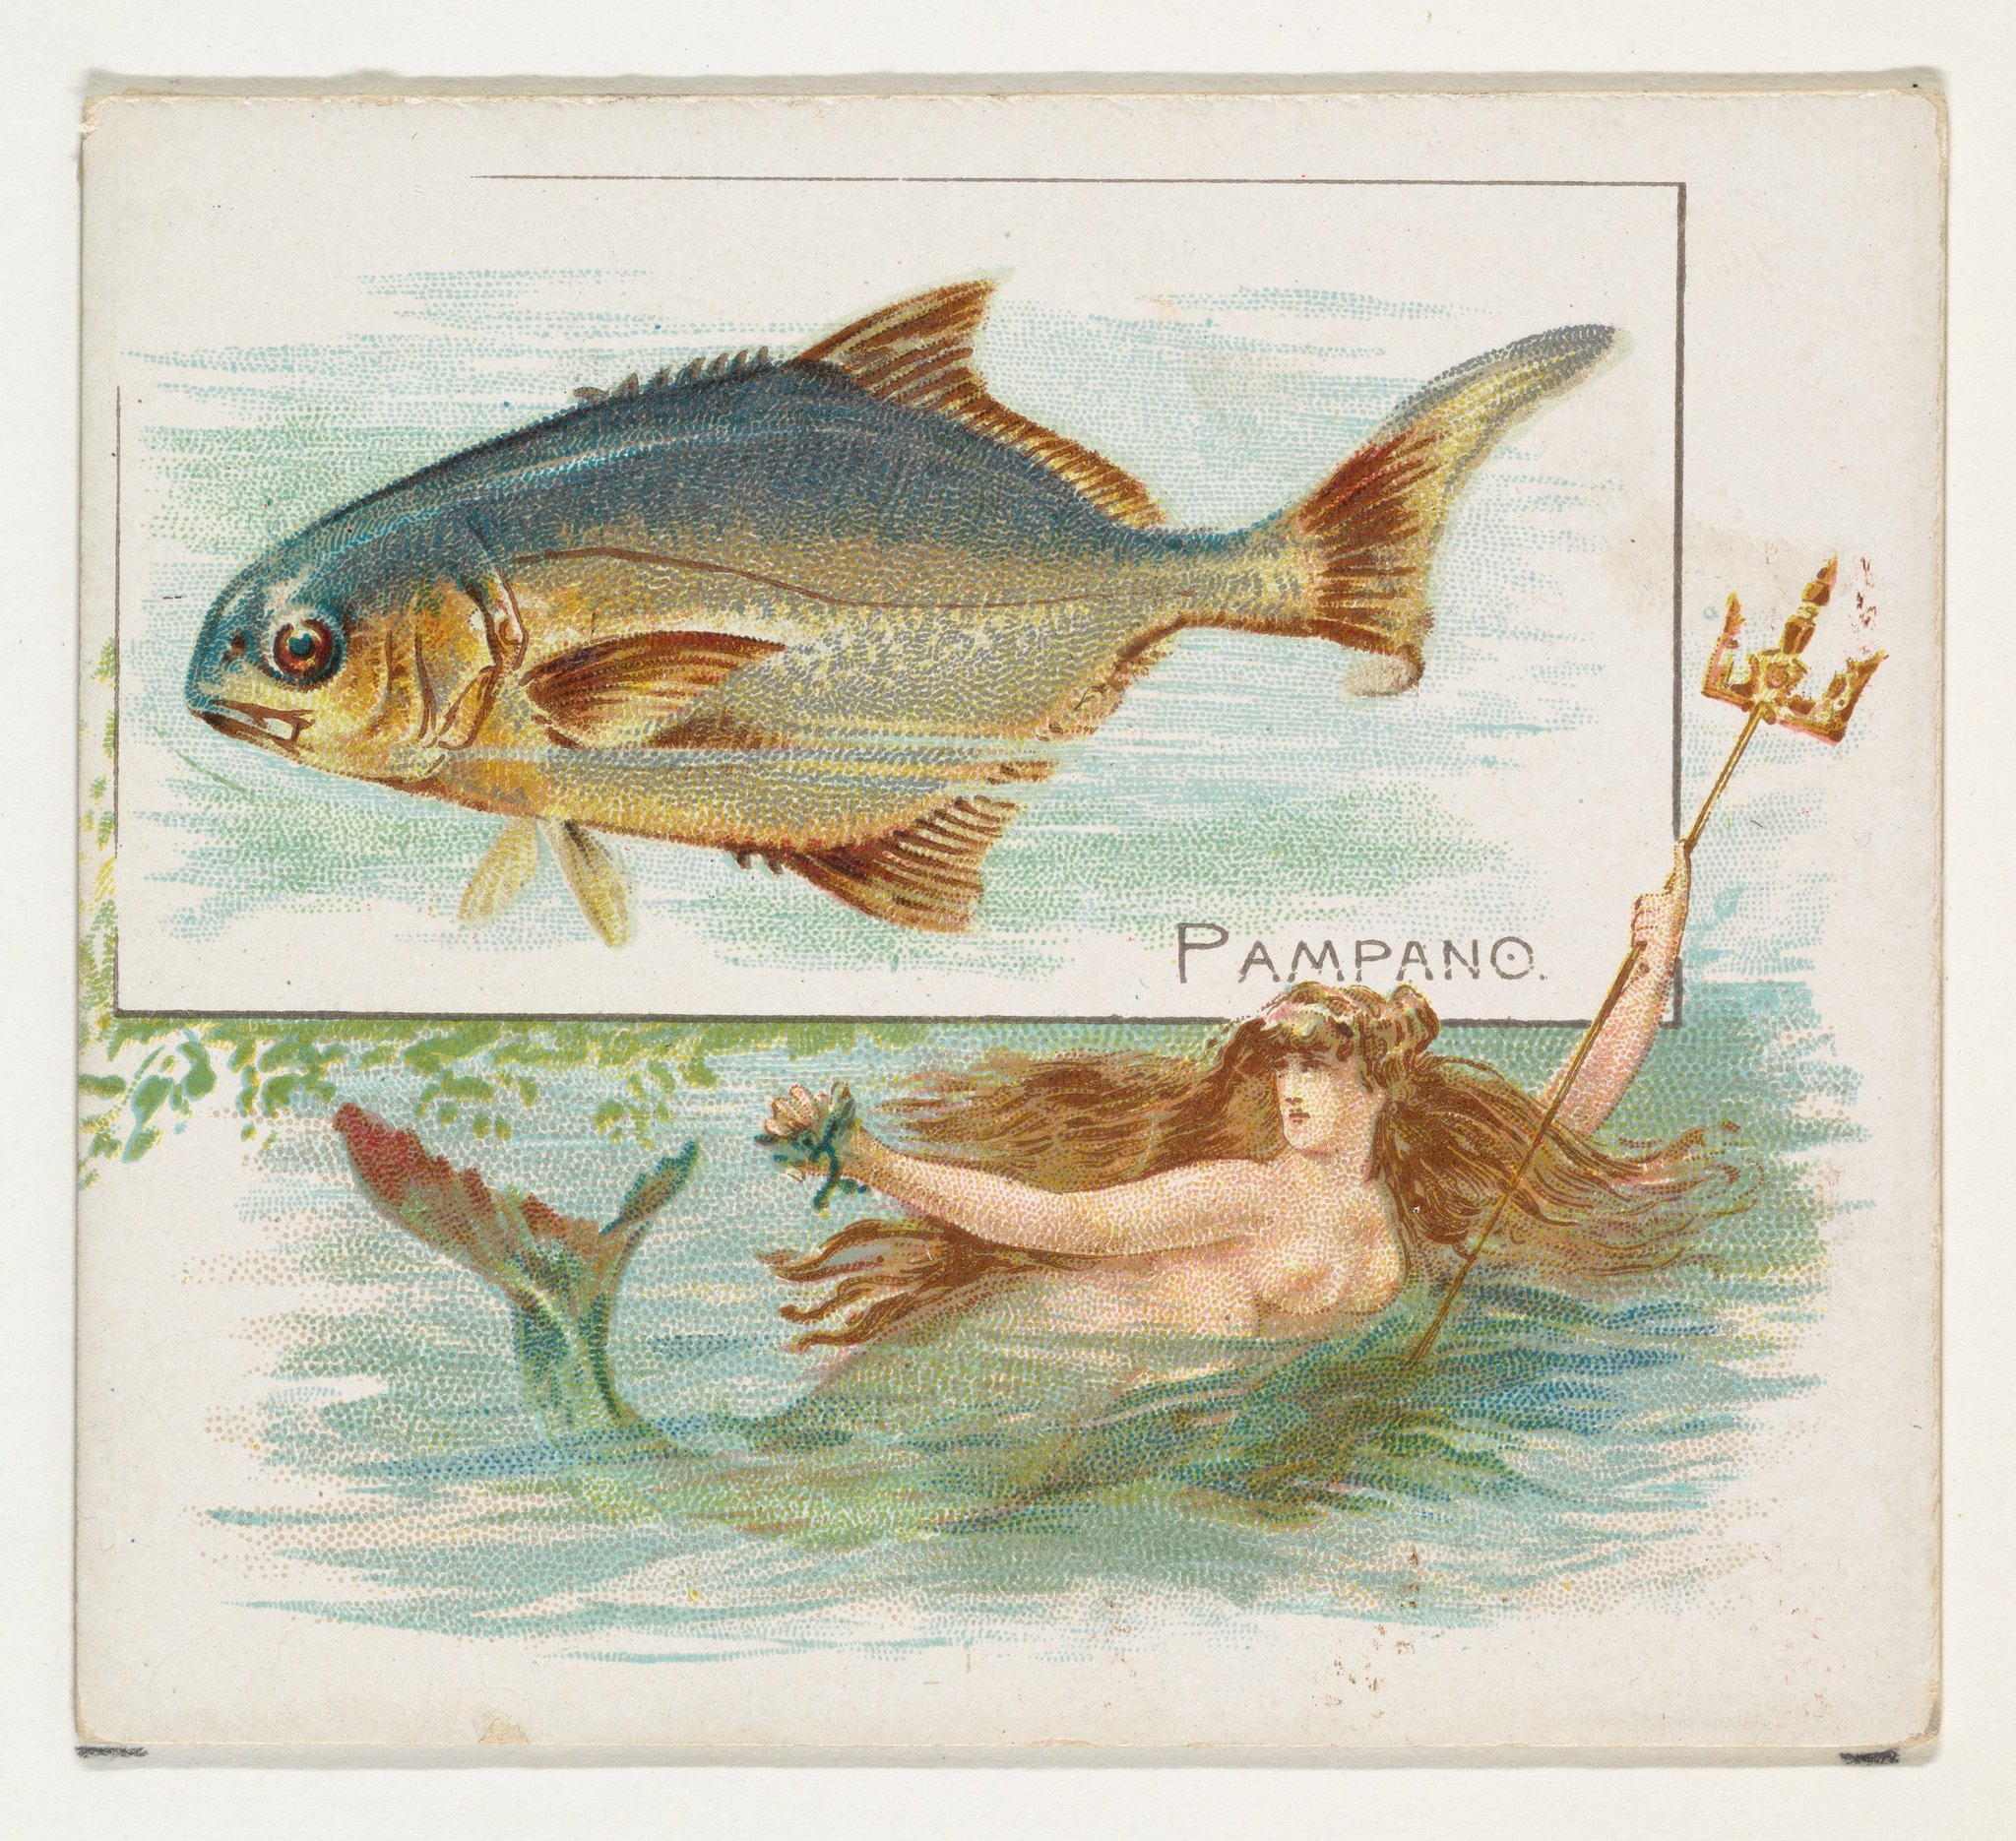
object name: print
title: Pampano, from Fish from American Waters series (N39) for Allen & Ginter Cigarettes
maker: allen & ginter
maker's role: publisher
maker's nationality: american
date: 1889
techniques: color lithograph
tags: mermaids,fish